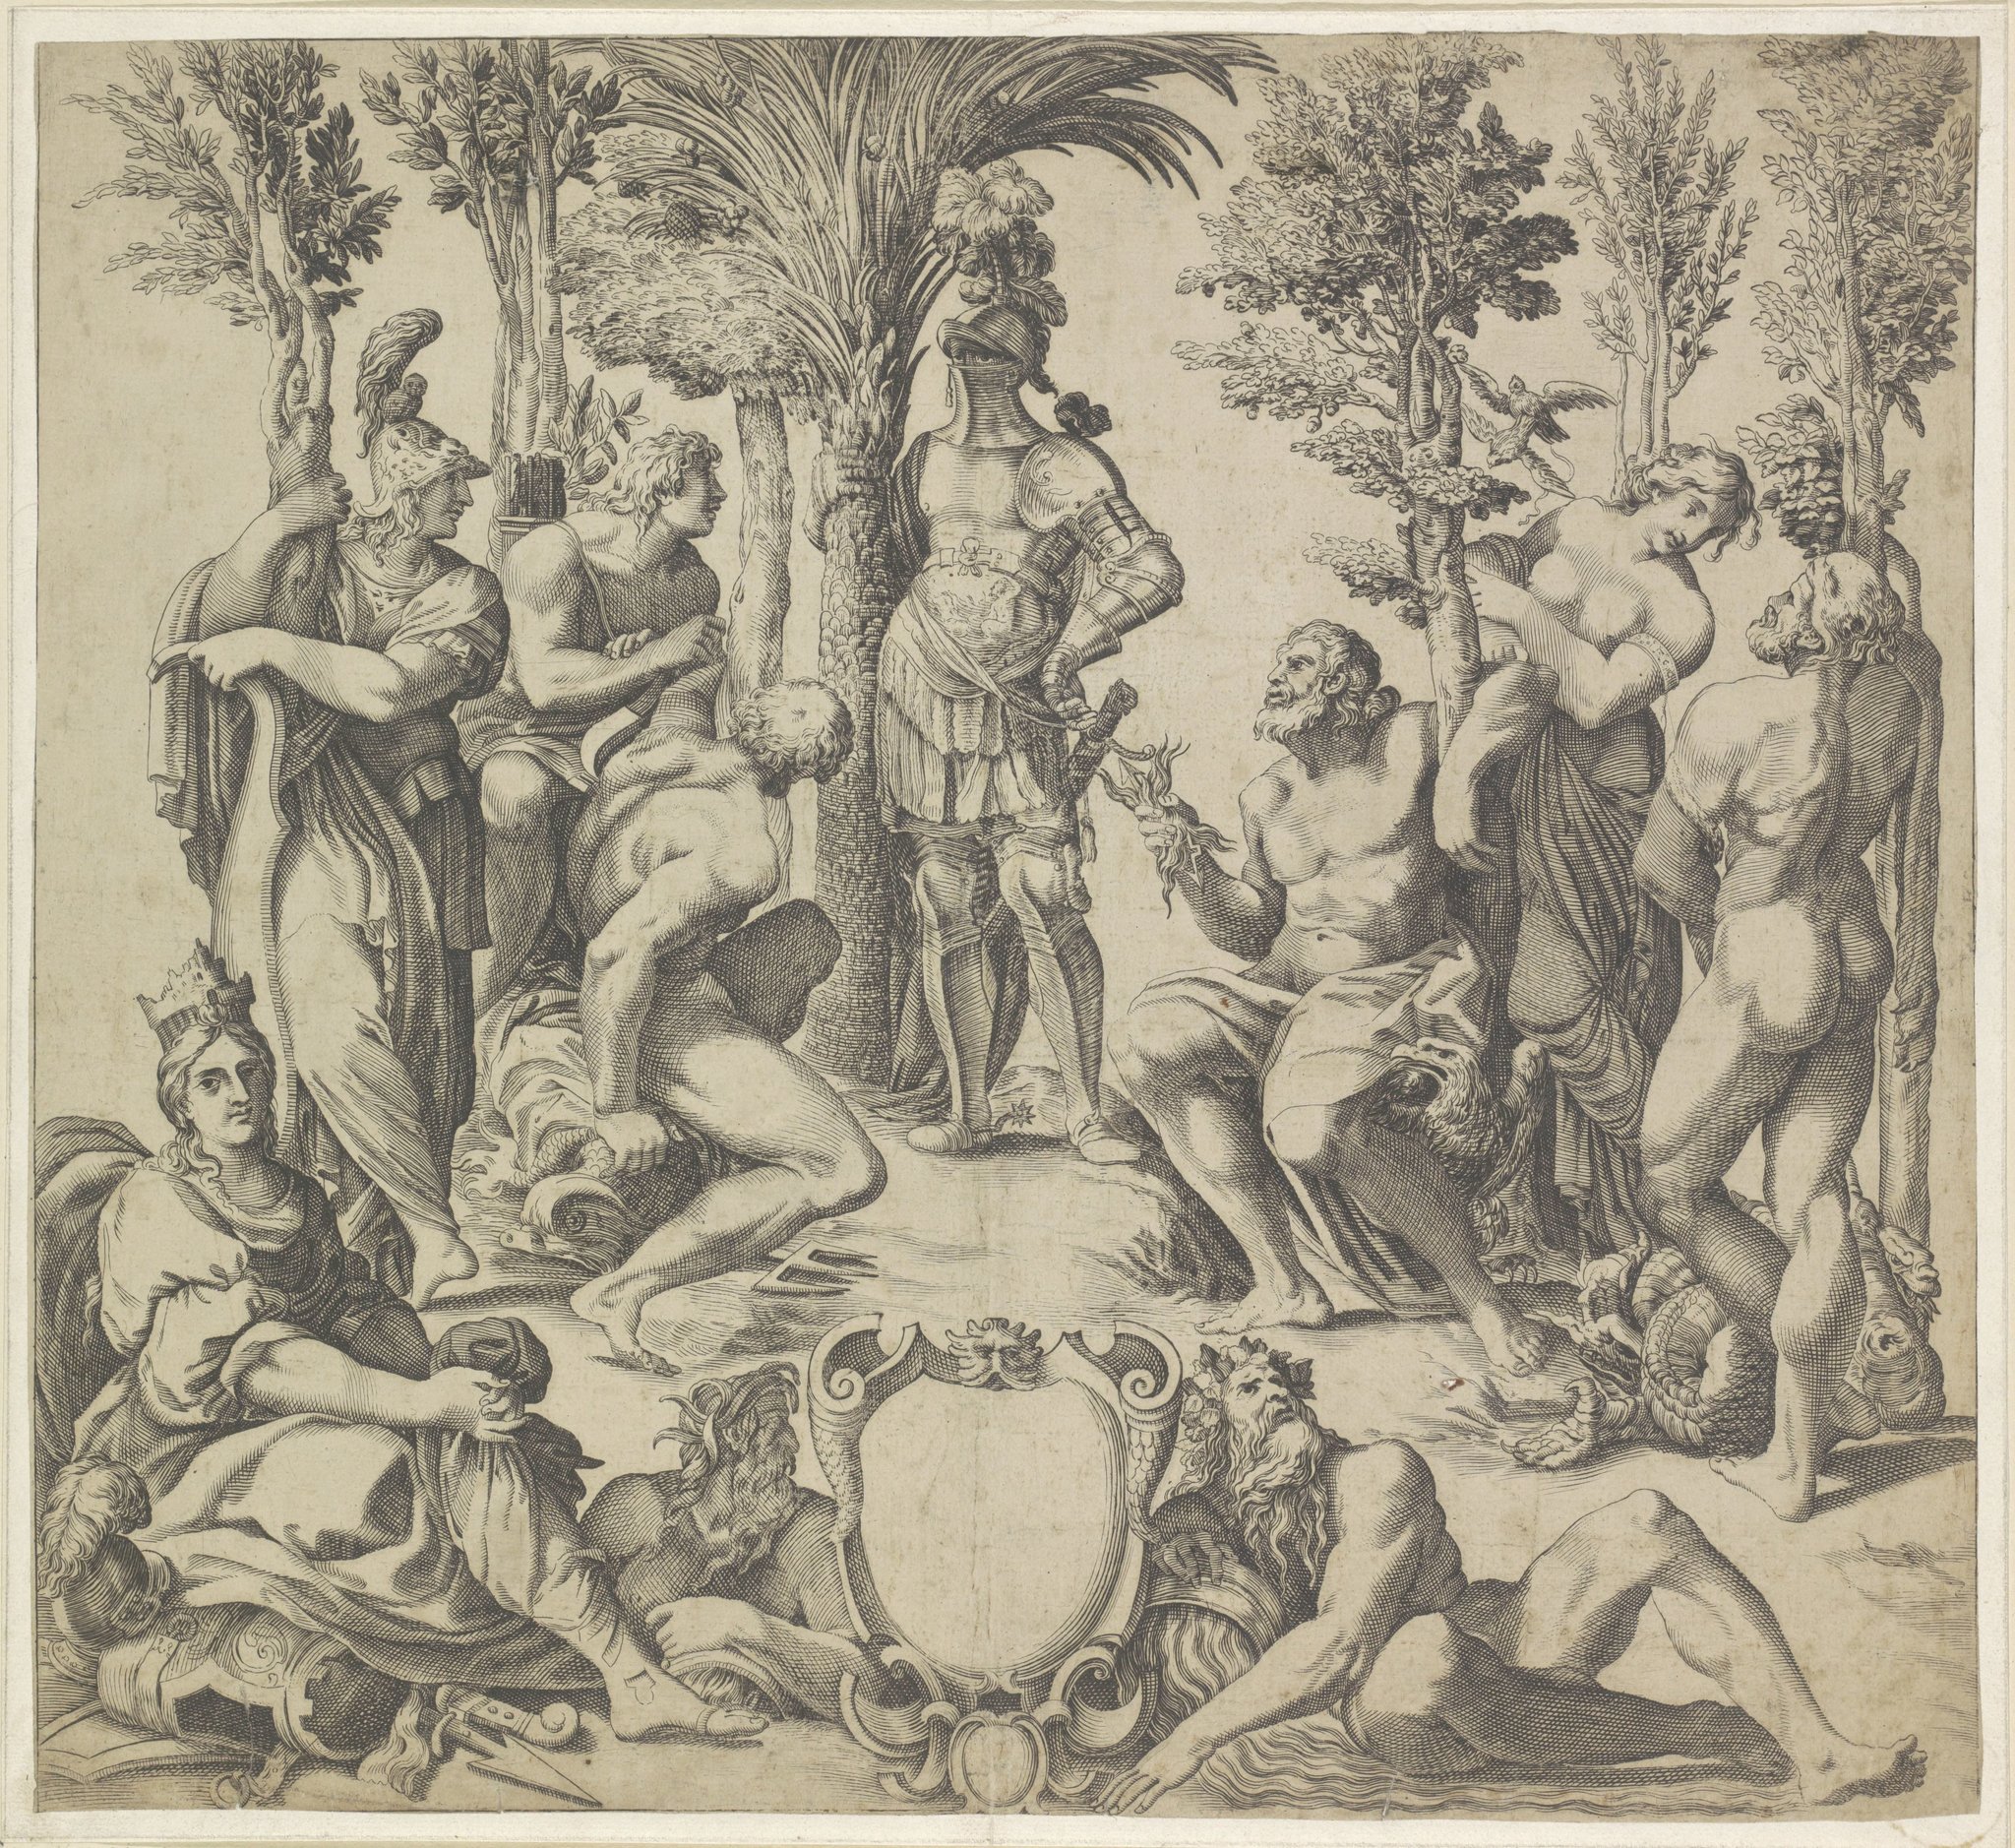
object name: print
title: Hertog van Mantua met de zes voornaamste Romeinse goden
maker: Anonymous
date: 1589-1626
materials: paper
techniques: engraving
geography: italy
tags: (story of) neptune (poseidon), (story of) hercules (heracles), (story of) apollo (phoebus), (story of) minerva (pallas, athena), (story of) jupiter (zeus), river-gods, (story of) venus (aphrodite), ruler, sovereign, gods ~ classical mythology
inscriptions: collector's mark: Lugt 240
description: De hertog van Mantua staat, in een harnas, naast een boom. Hij wordt aan weerszijden geflankeerd door drie heidense goden (Minerva, Apollo, Neptunus, Jupiter, Venus en Hercules). Op de voorgrond een leeg wapenschild, twee riviergoden en een zittende vrouwenfiguur op een stapel wapens.